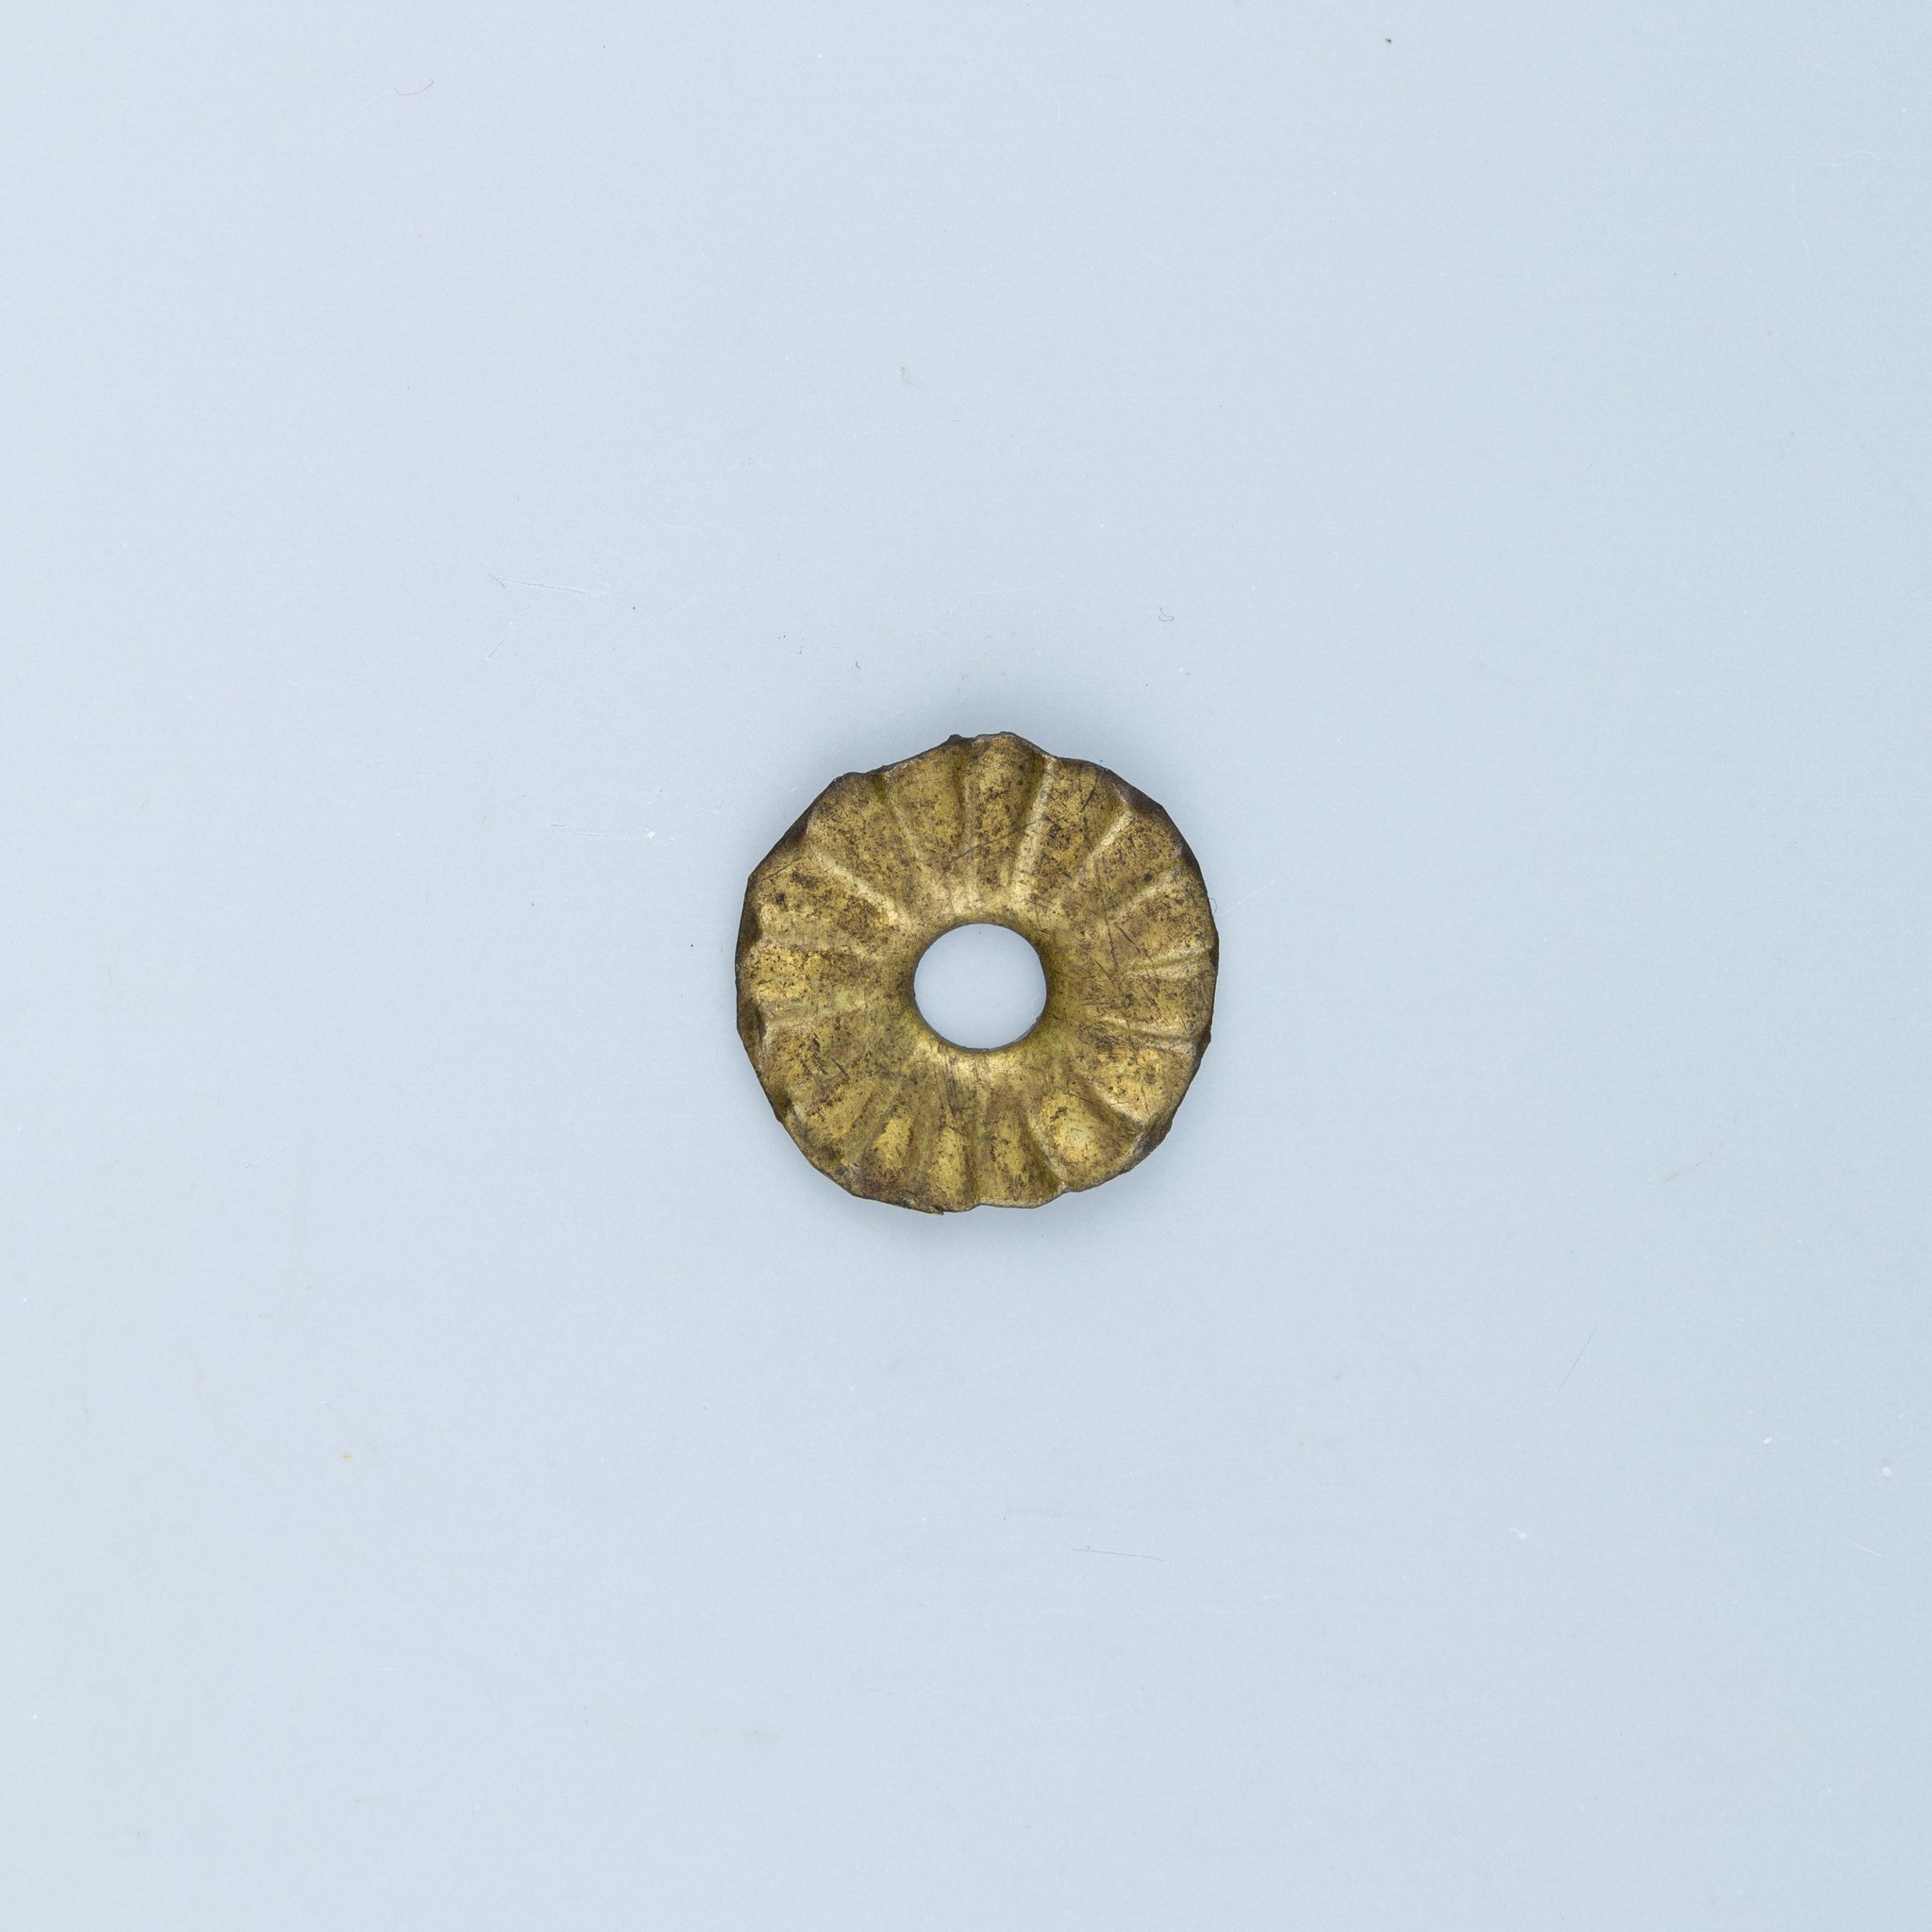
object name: rosette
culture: italian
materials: brass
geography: italy